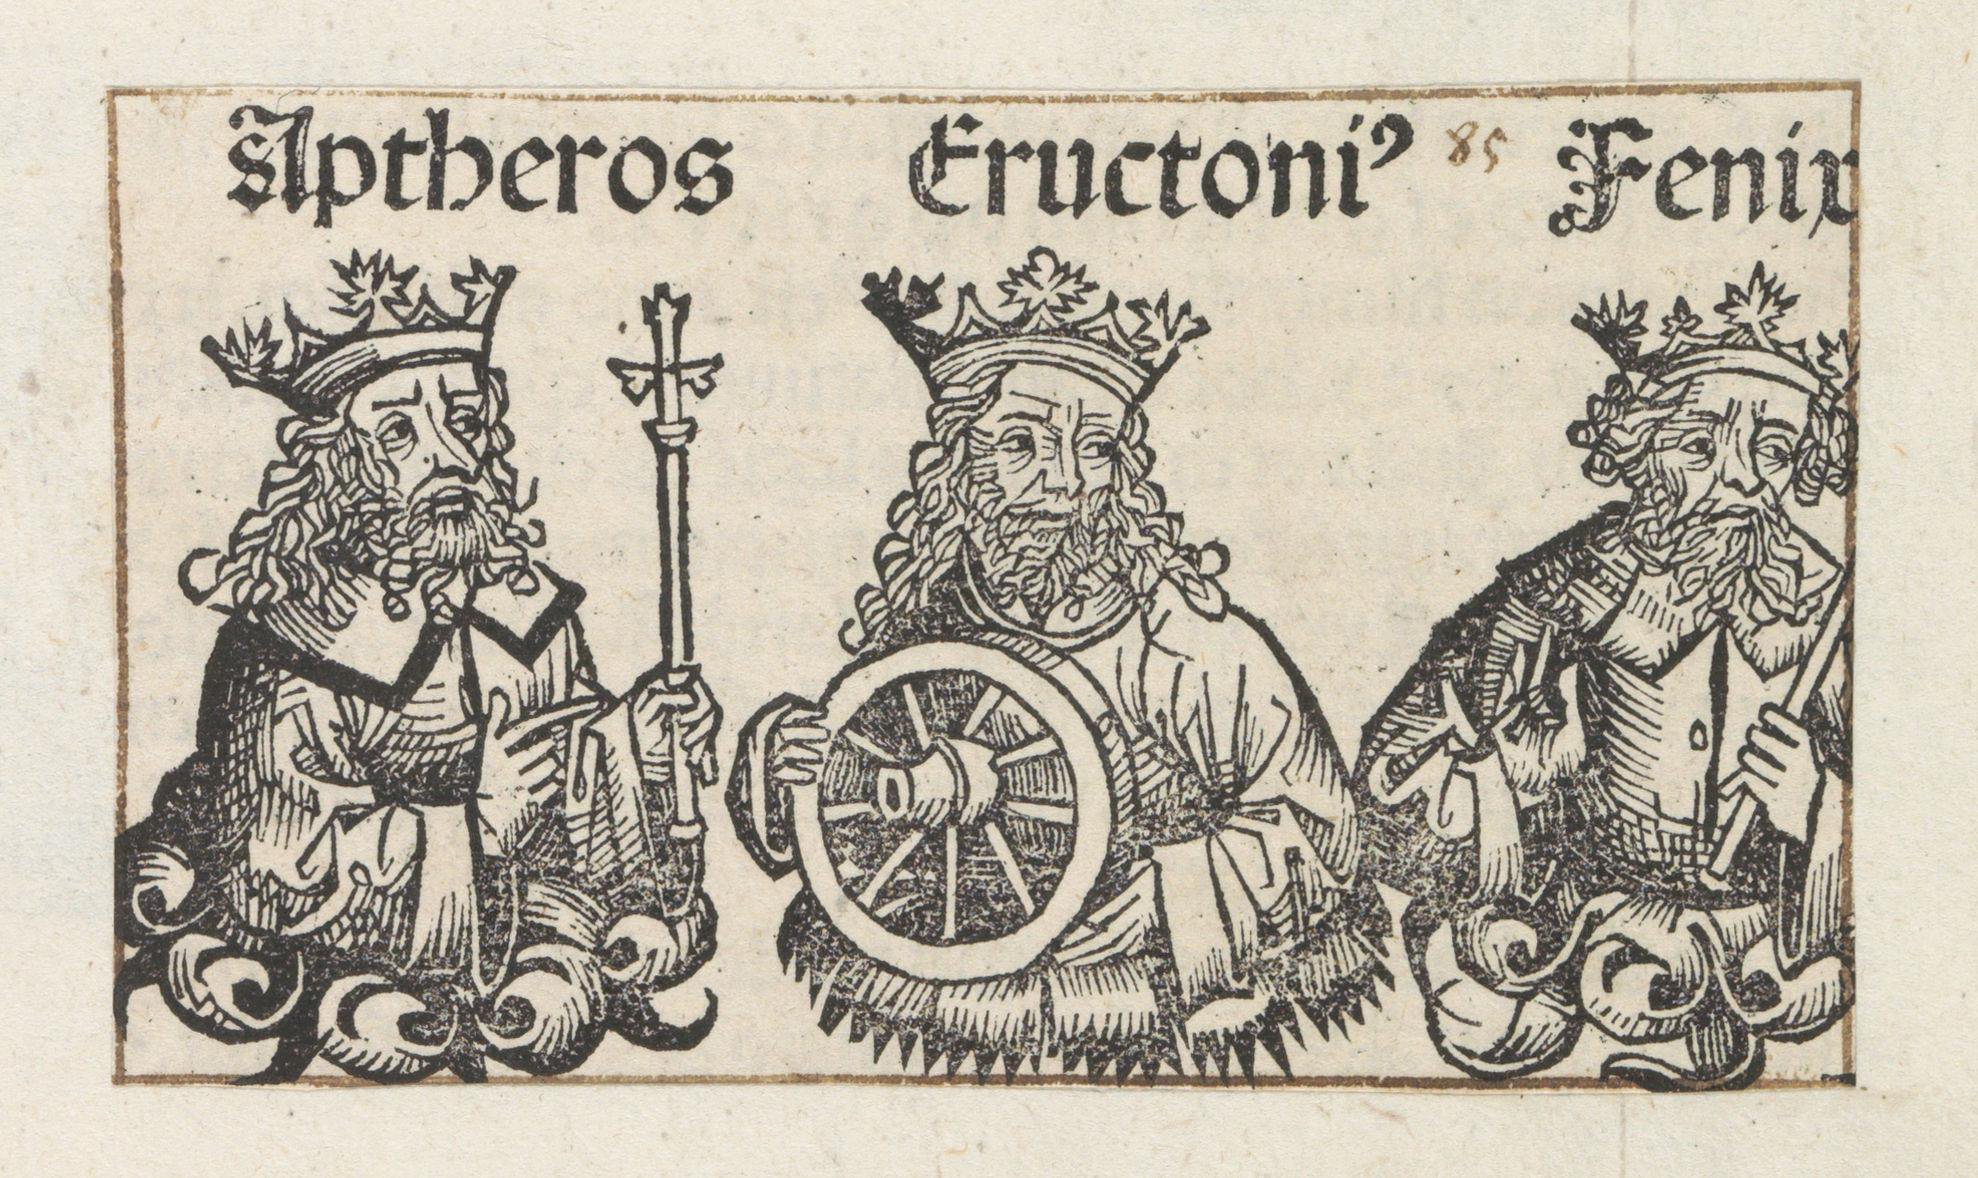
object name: book illustration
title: Aptheros / Eructoni[us] / Fenix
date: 1493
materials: paper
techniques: letterpress printing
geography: nuremberg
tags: king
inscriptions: inscription: ‘85’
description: De houtsnede wordt gebruikt als boekillustratie in de Liber Chronicarum (of Neurenbergkroniek) van Hartmann Schedel, verschenen in het Latijn en Duits in 1493. Zie de Latijnse uitgave, folio 34r.